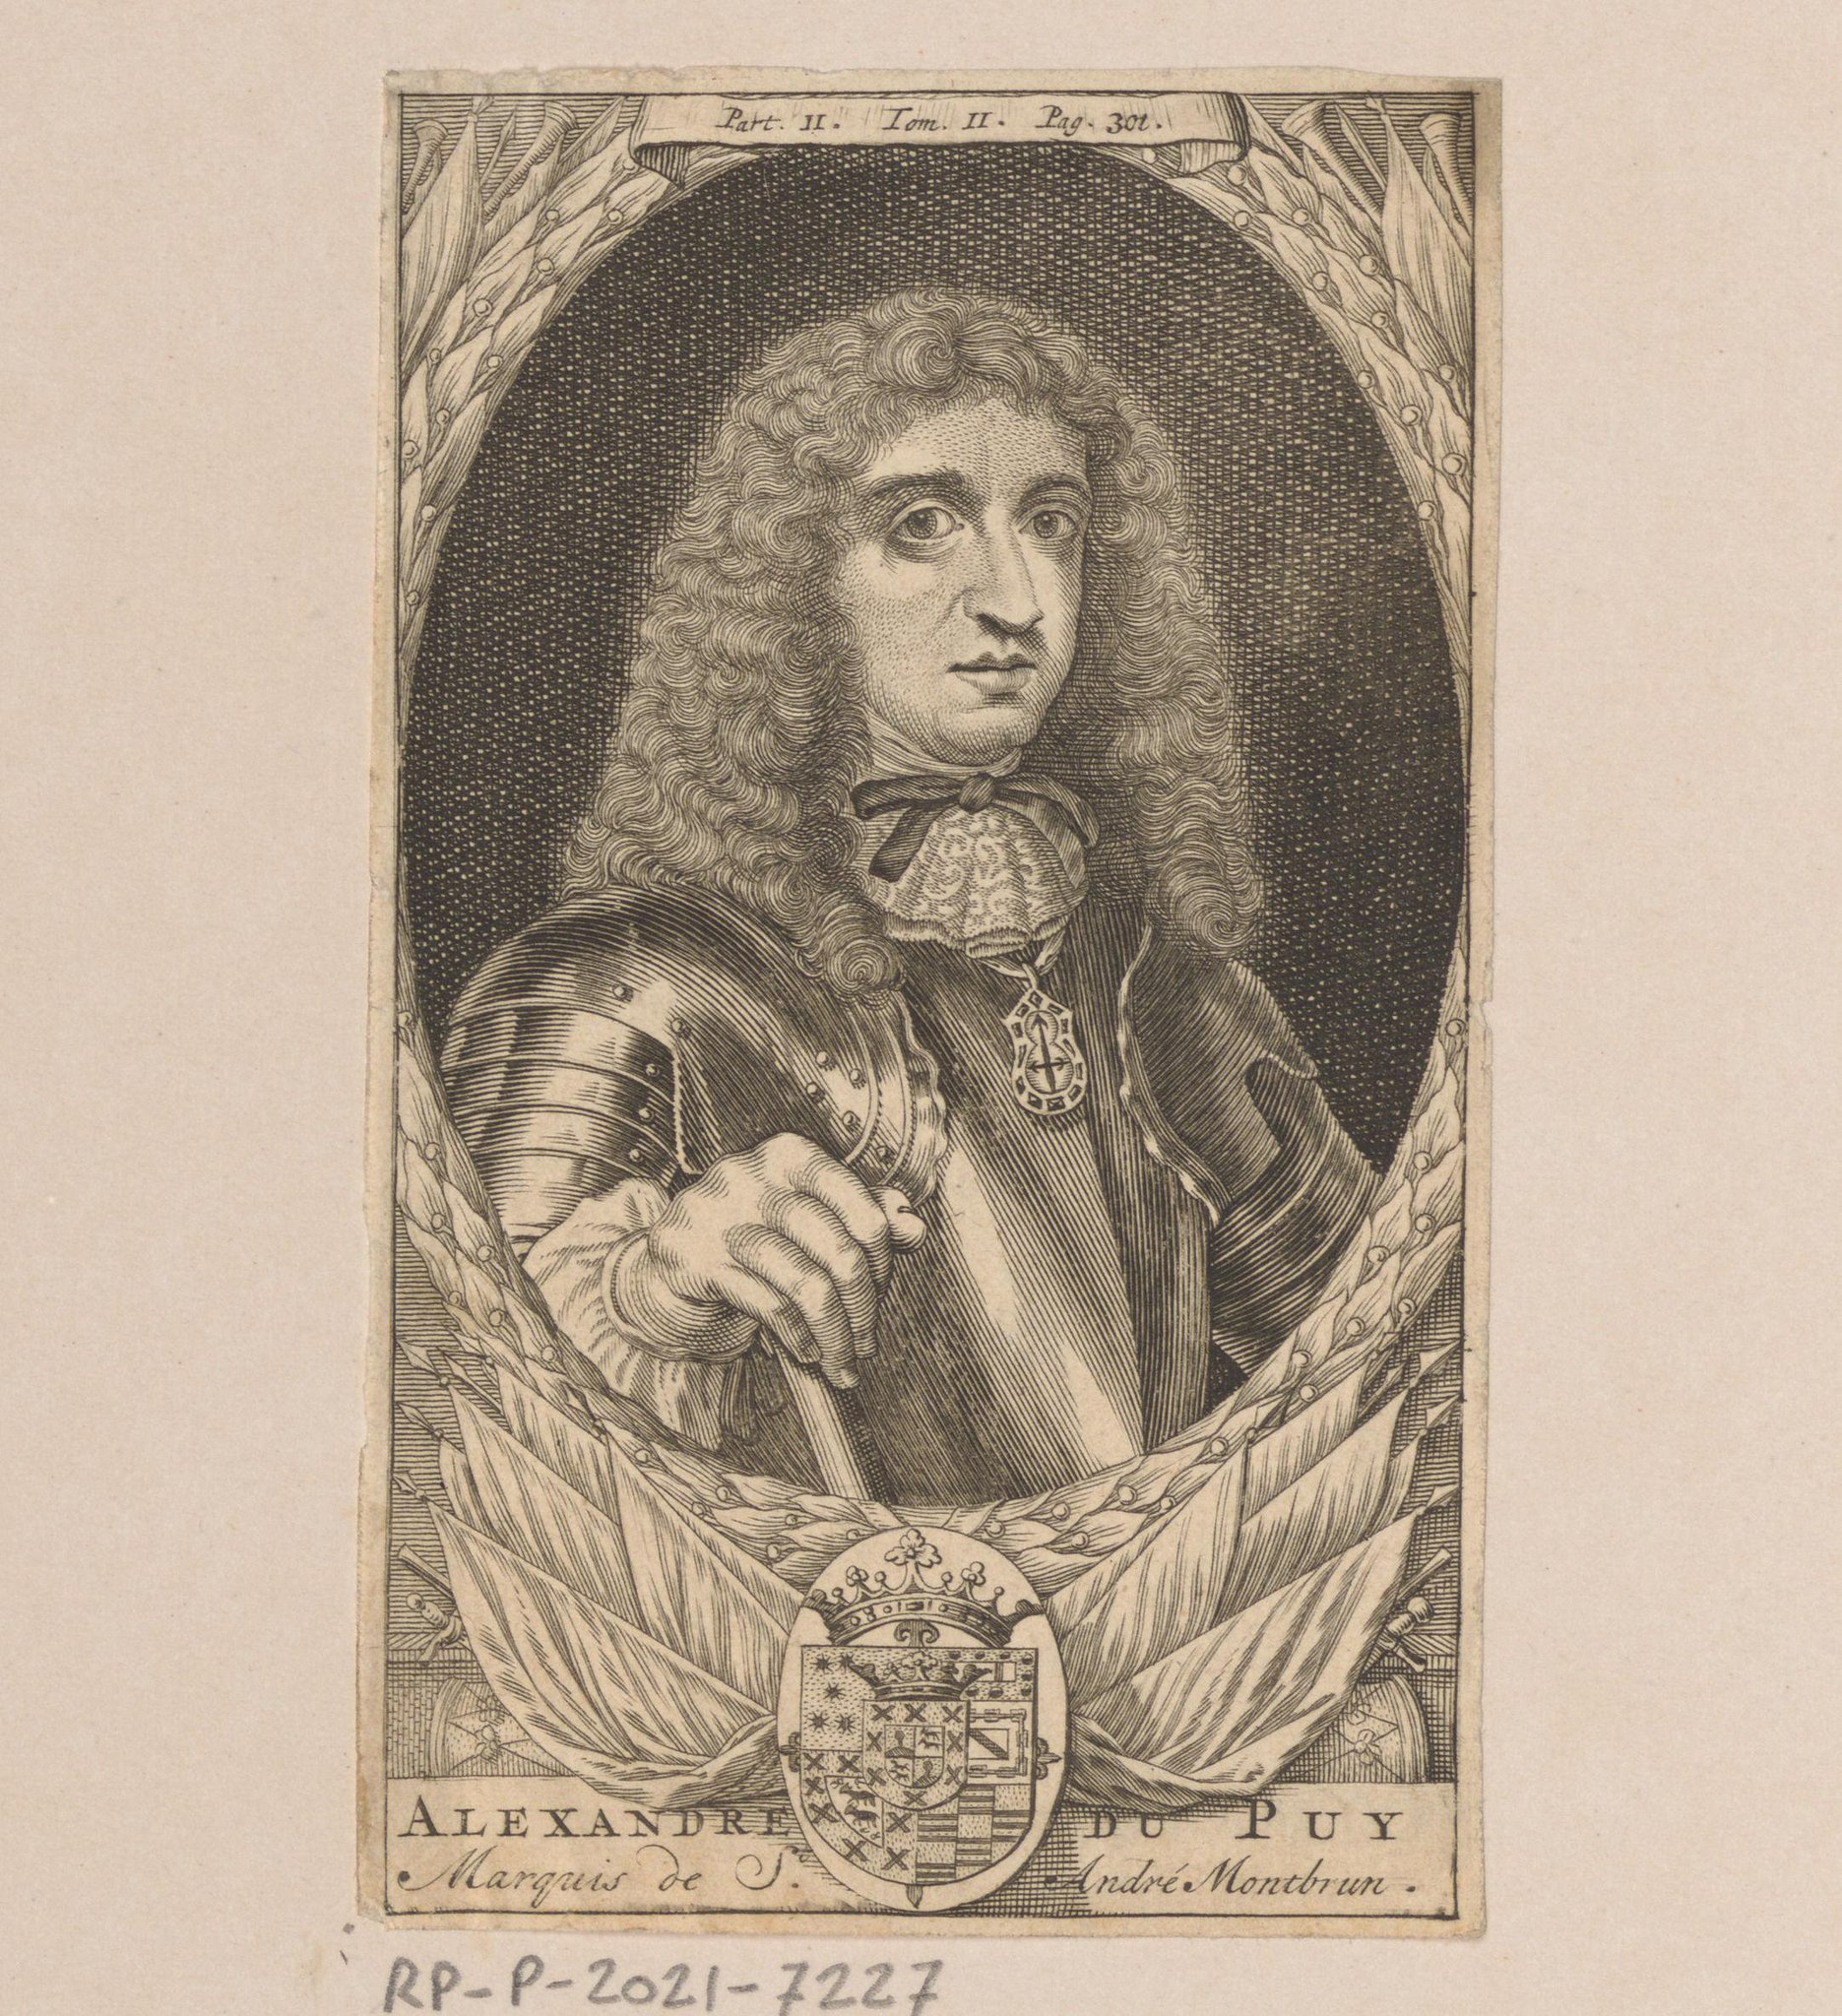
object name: print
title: Portret van Alexander du Puy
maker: Anonymous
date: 1702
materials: paper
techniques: engraving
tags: military service, historical persons, armorial bearing, heraldry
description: Prent mogelijk uit: Nani, Baptiste. Histoire de la République de Venise (...). Amsterdam: Henri Schelte, 1702, dl. 2.